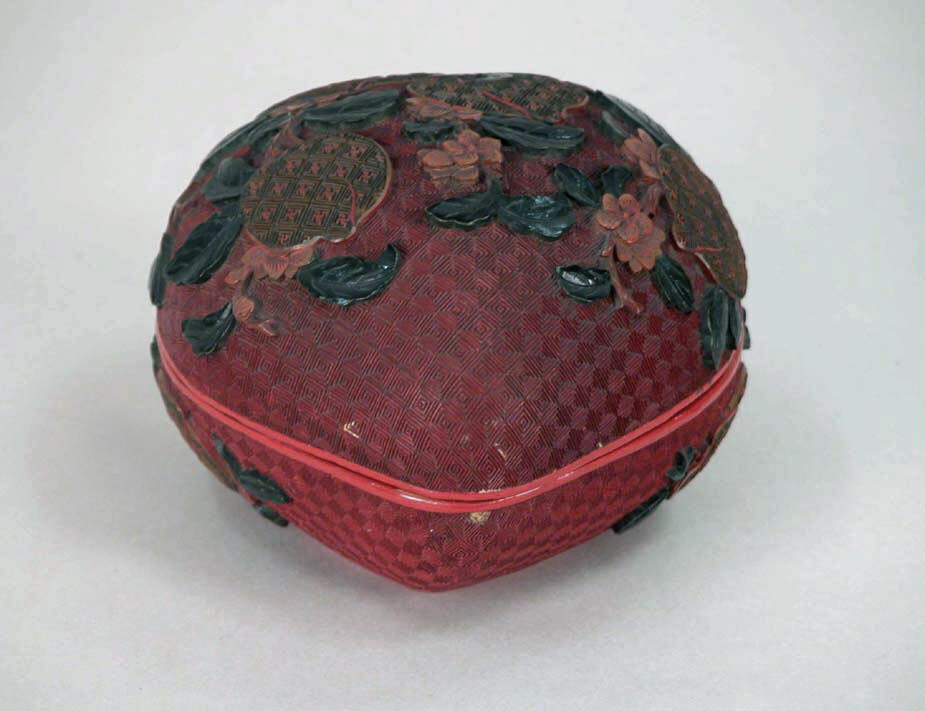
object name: box with cover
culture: chinese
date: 1736-1795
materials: lacquer